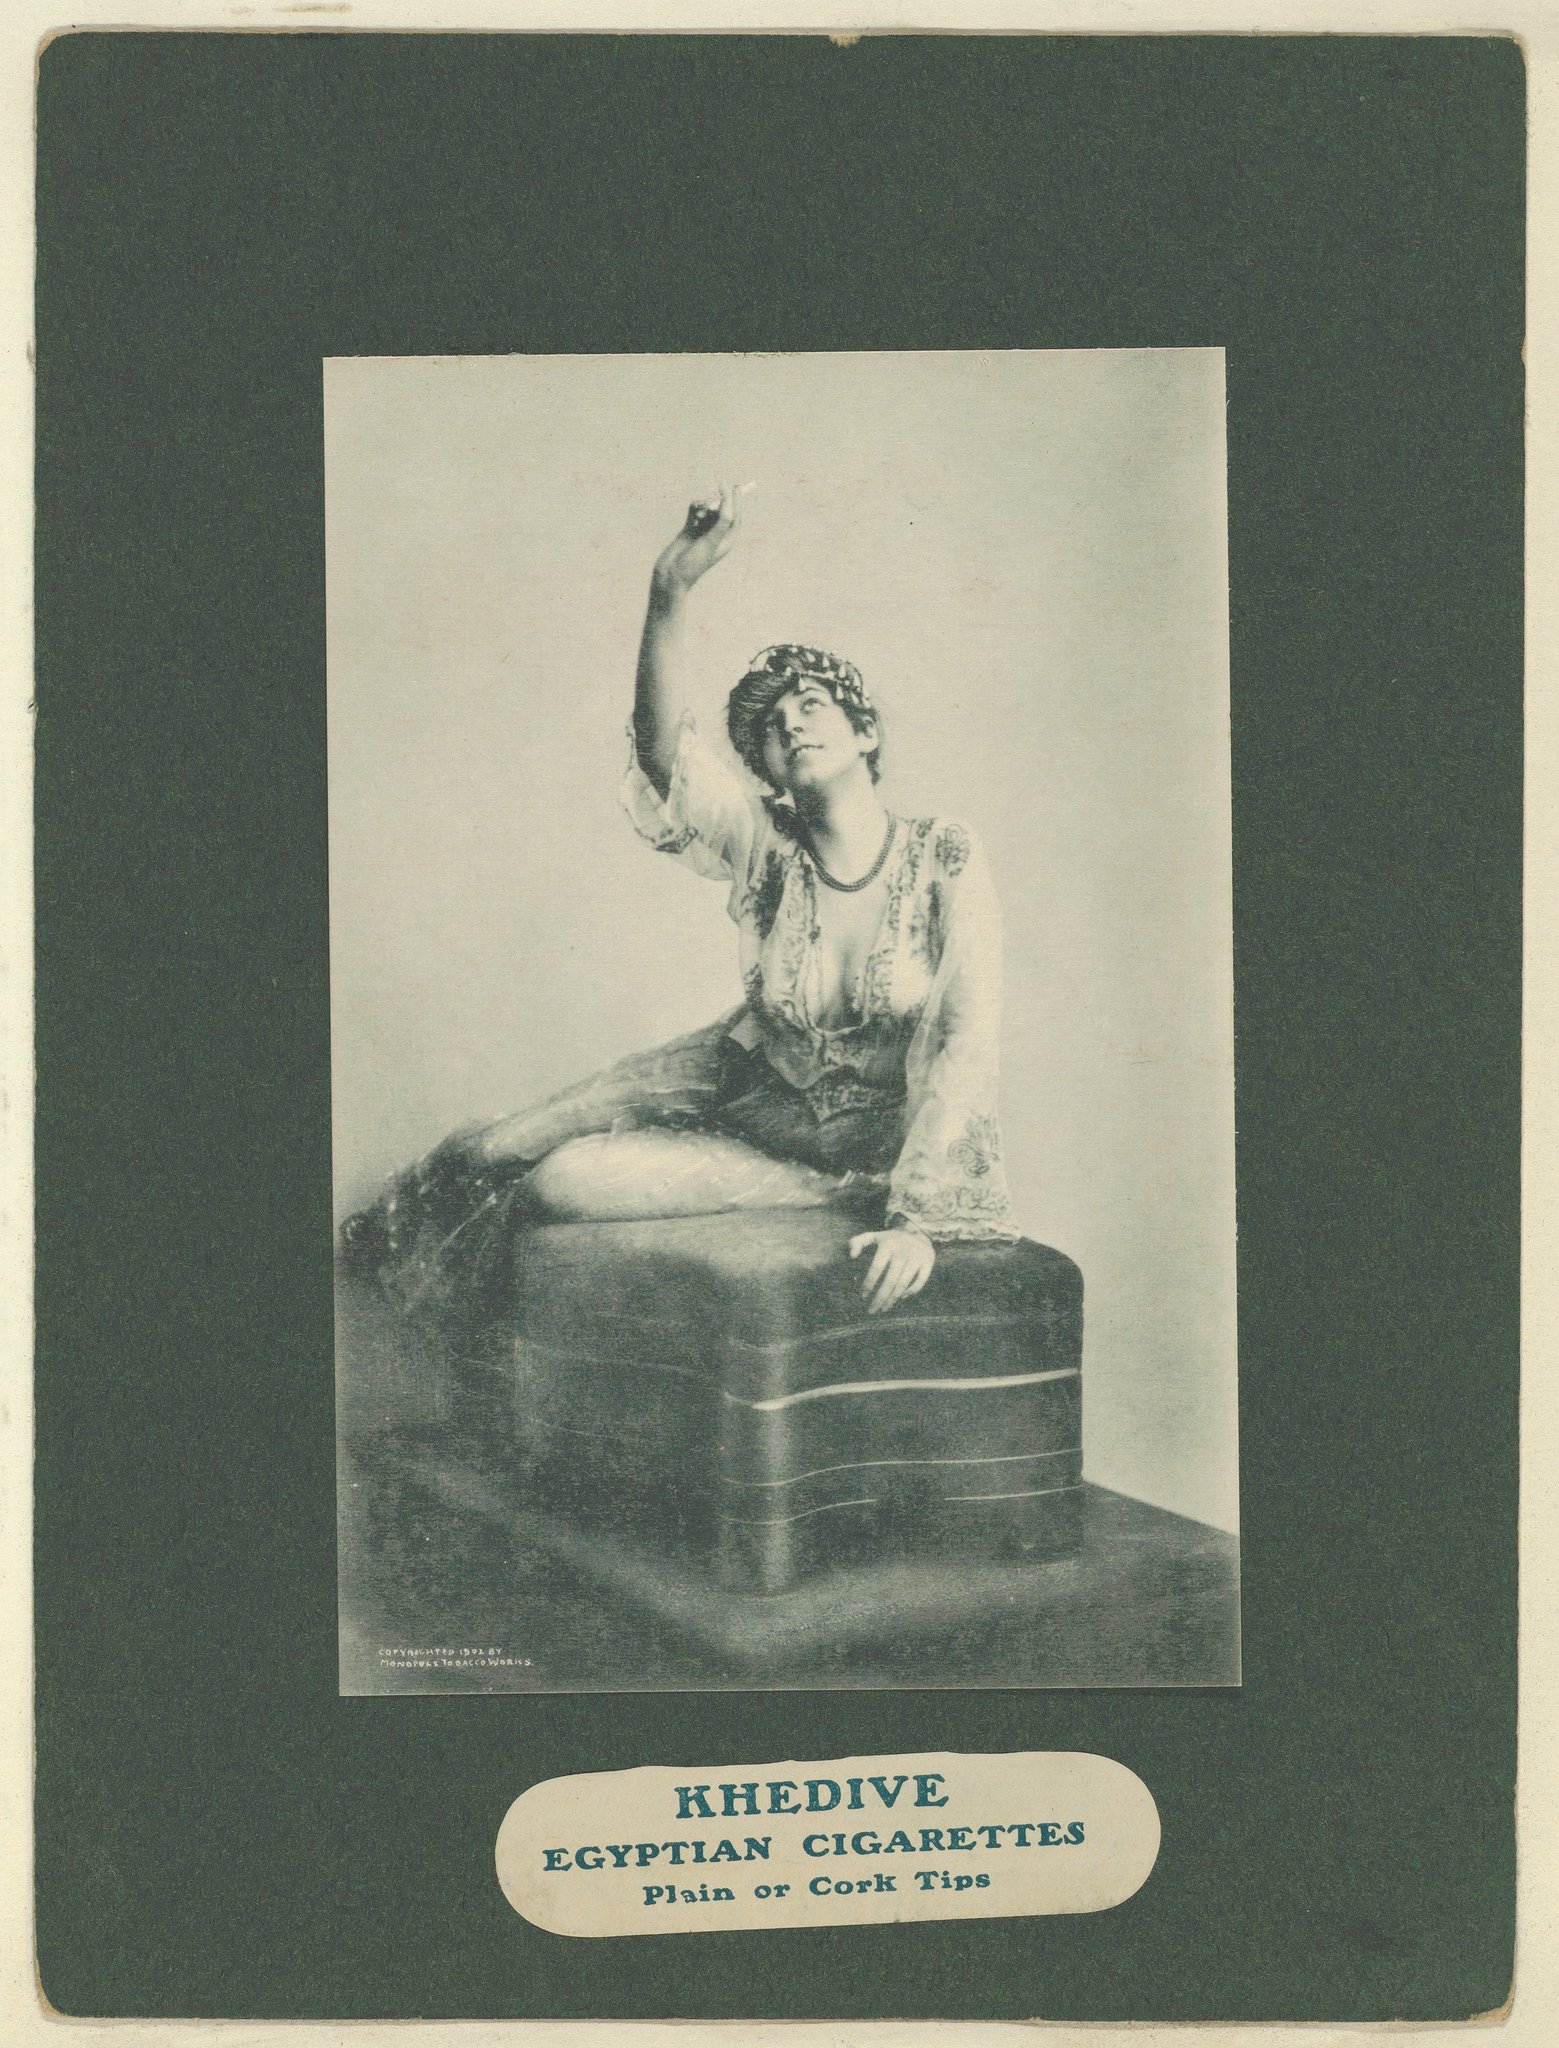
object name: print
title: Plate 8, from Little Egypt Actresses series (T2), issued by Monopole Tobacco Works to promote Khedive Egyptian Cigarettes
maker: monopole tobacco works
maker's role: publisher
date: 1902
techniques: photolithograph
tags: portraits,women,actresses